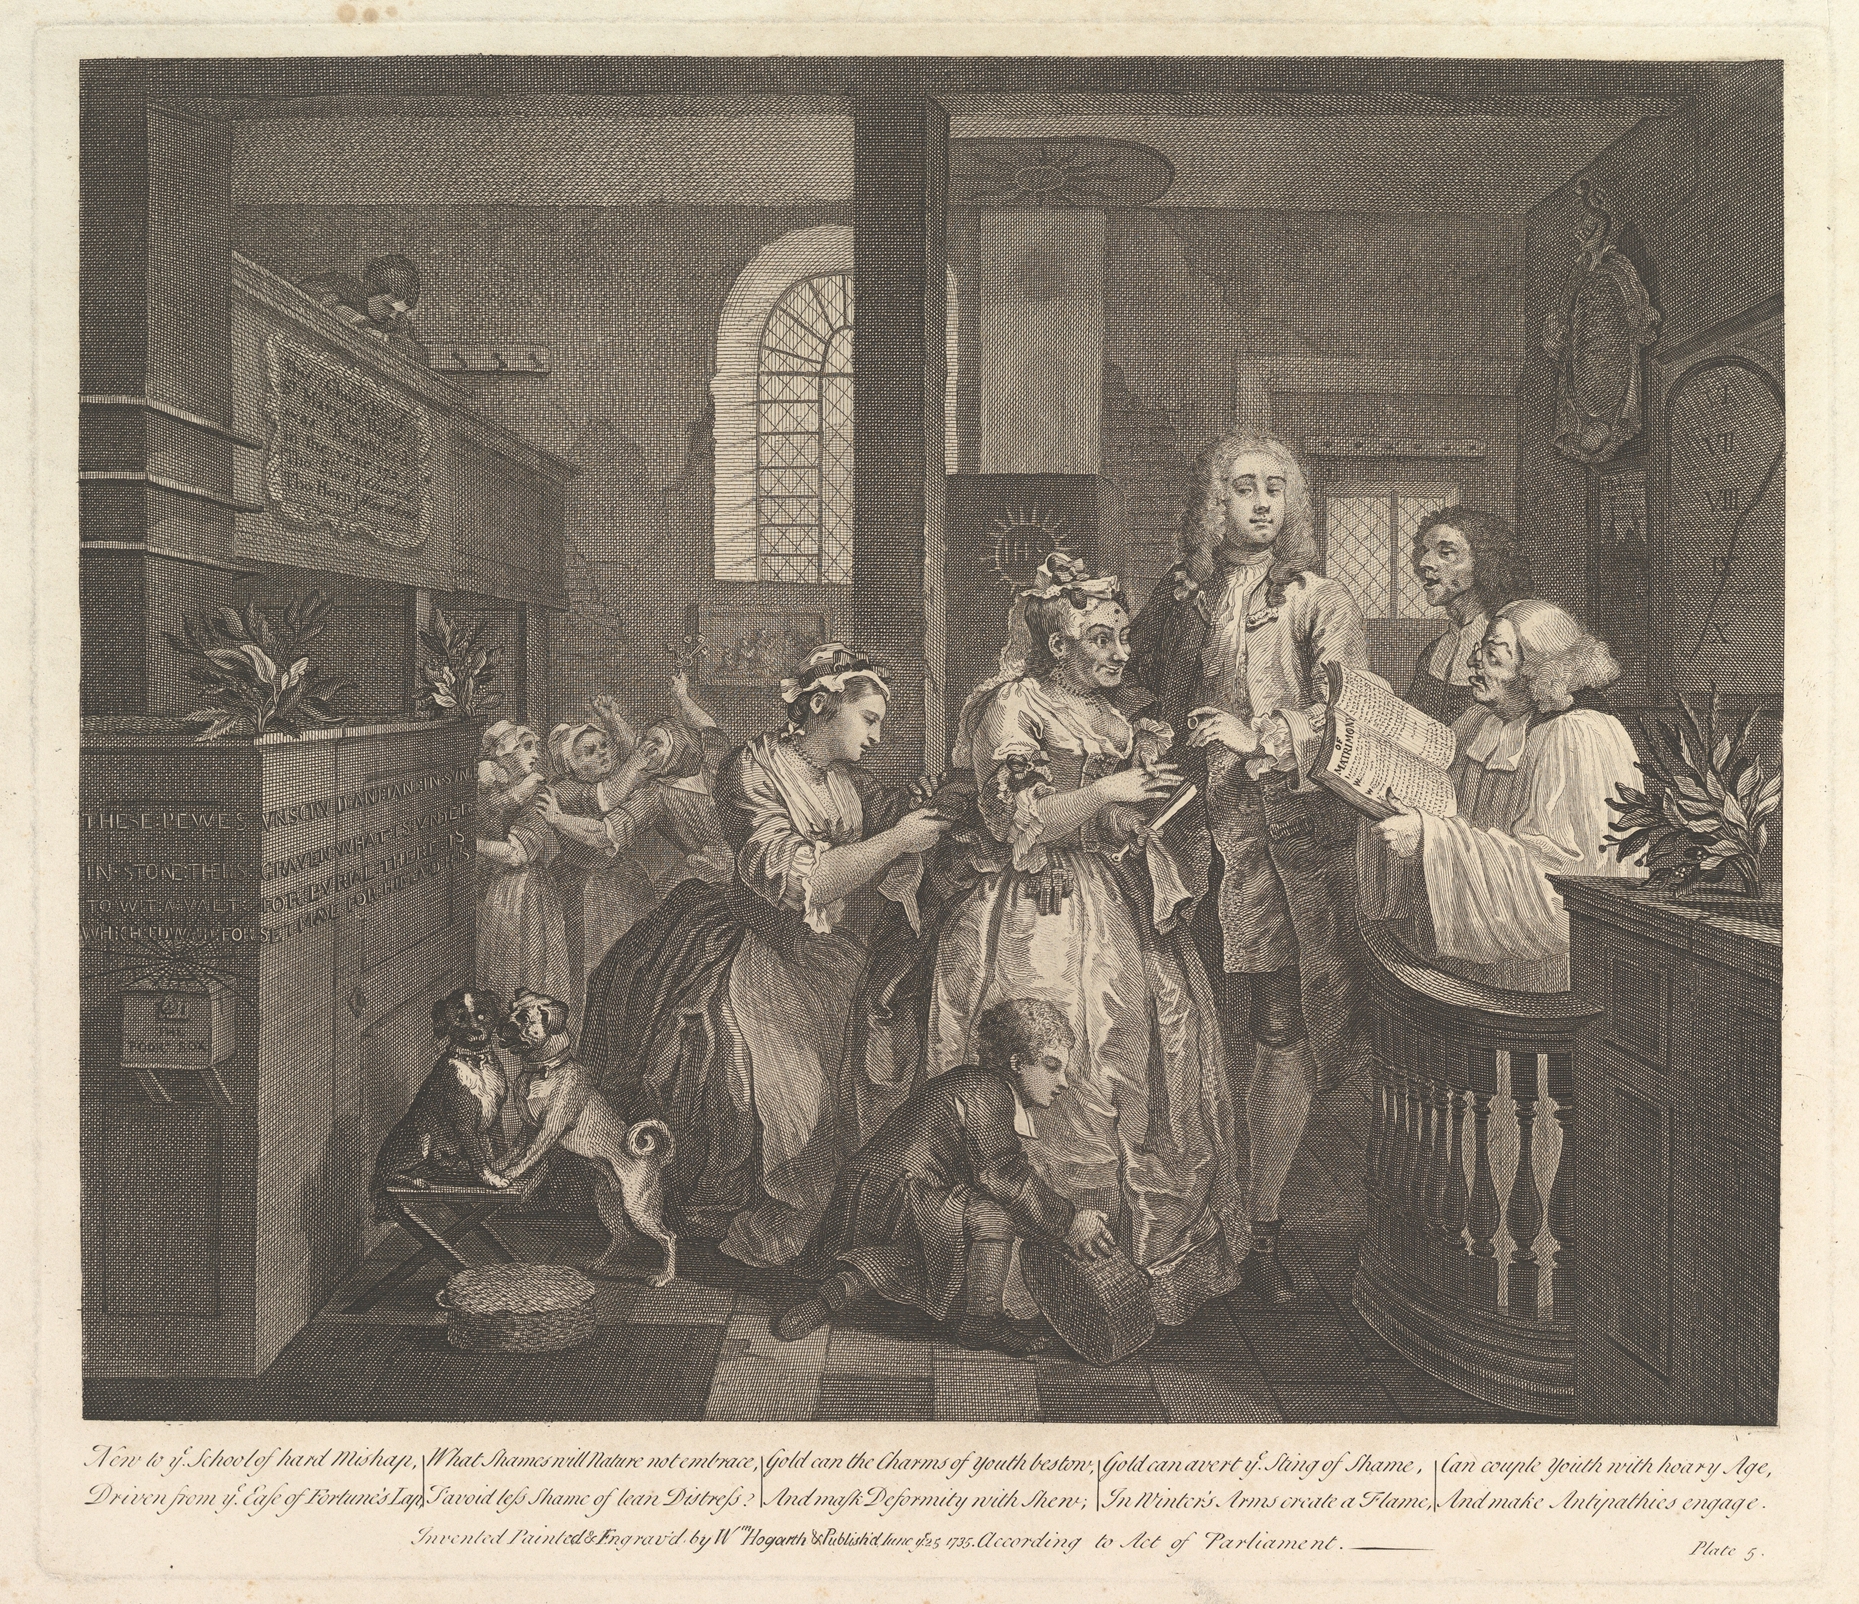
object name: print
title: A Rake's Progress, Plate 5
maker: william hogarth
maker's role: artist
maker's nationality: british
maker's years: 1697-1764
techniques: engraving, etching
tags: interiors,boys,men,women,dogs,weddings